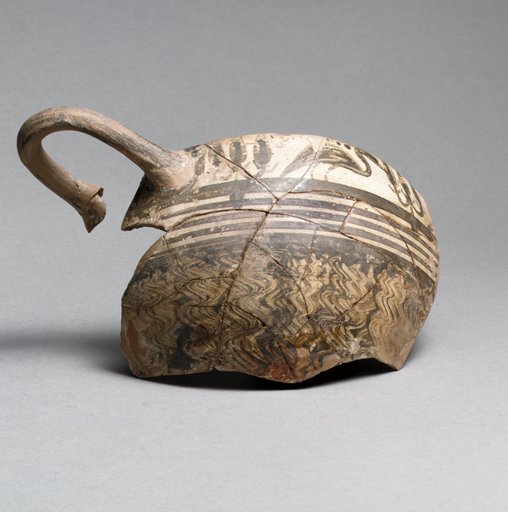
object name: vase fragment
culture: greek or lydian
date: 900-30 BCE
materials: terracotta